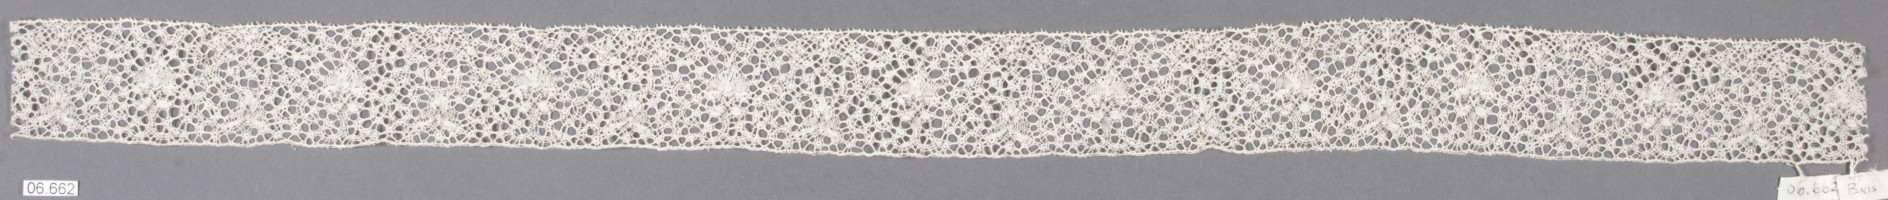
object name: fragment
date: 1700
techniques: lace